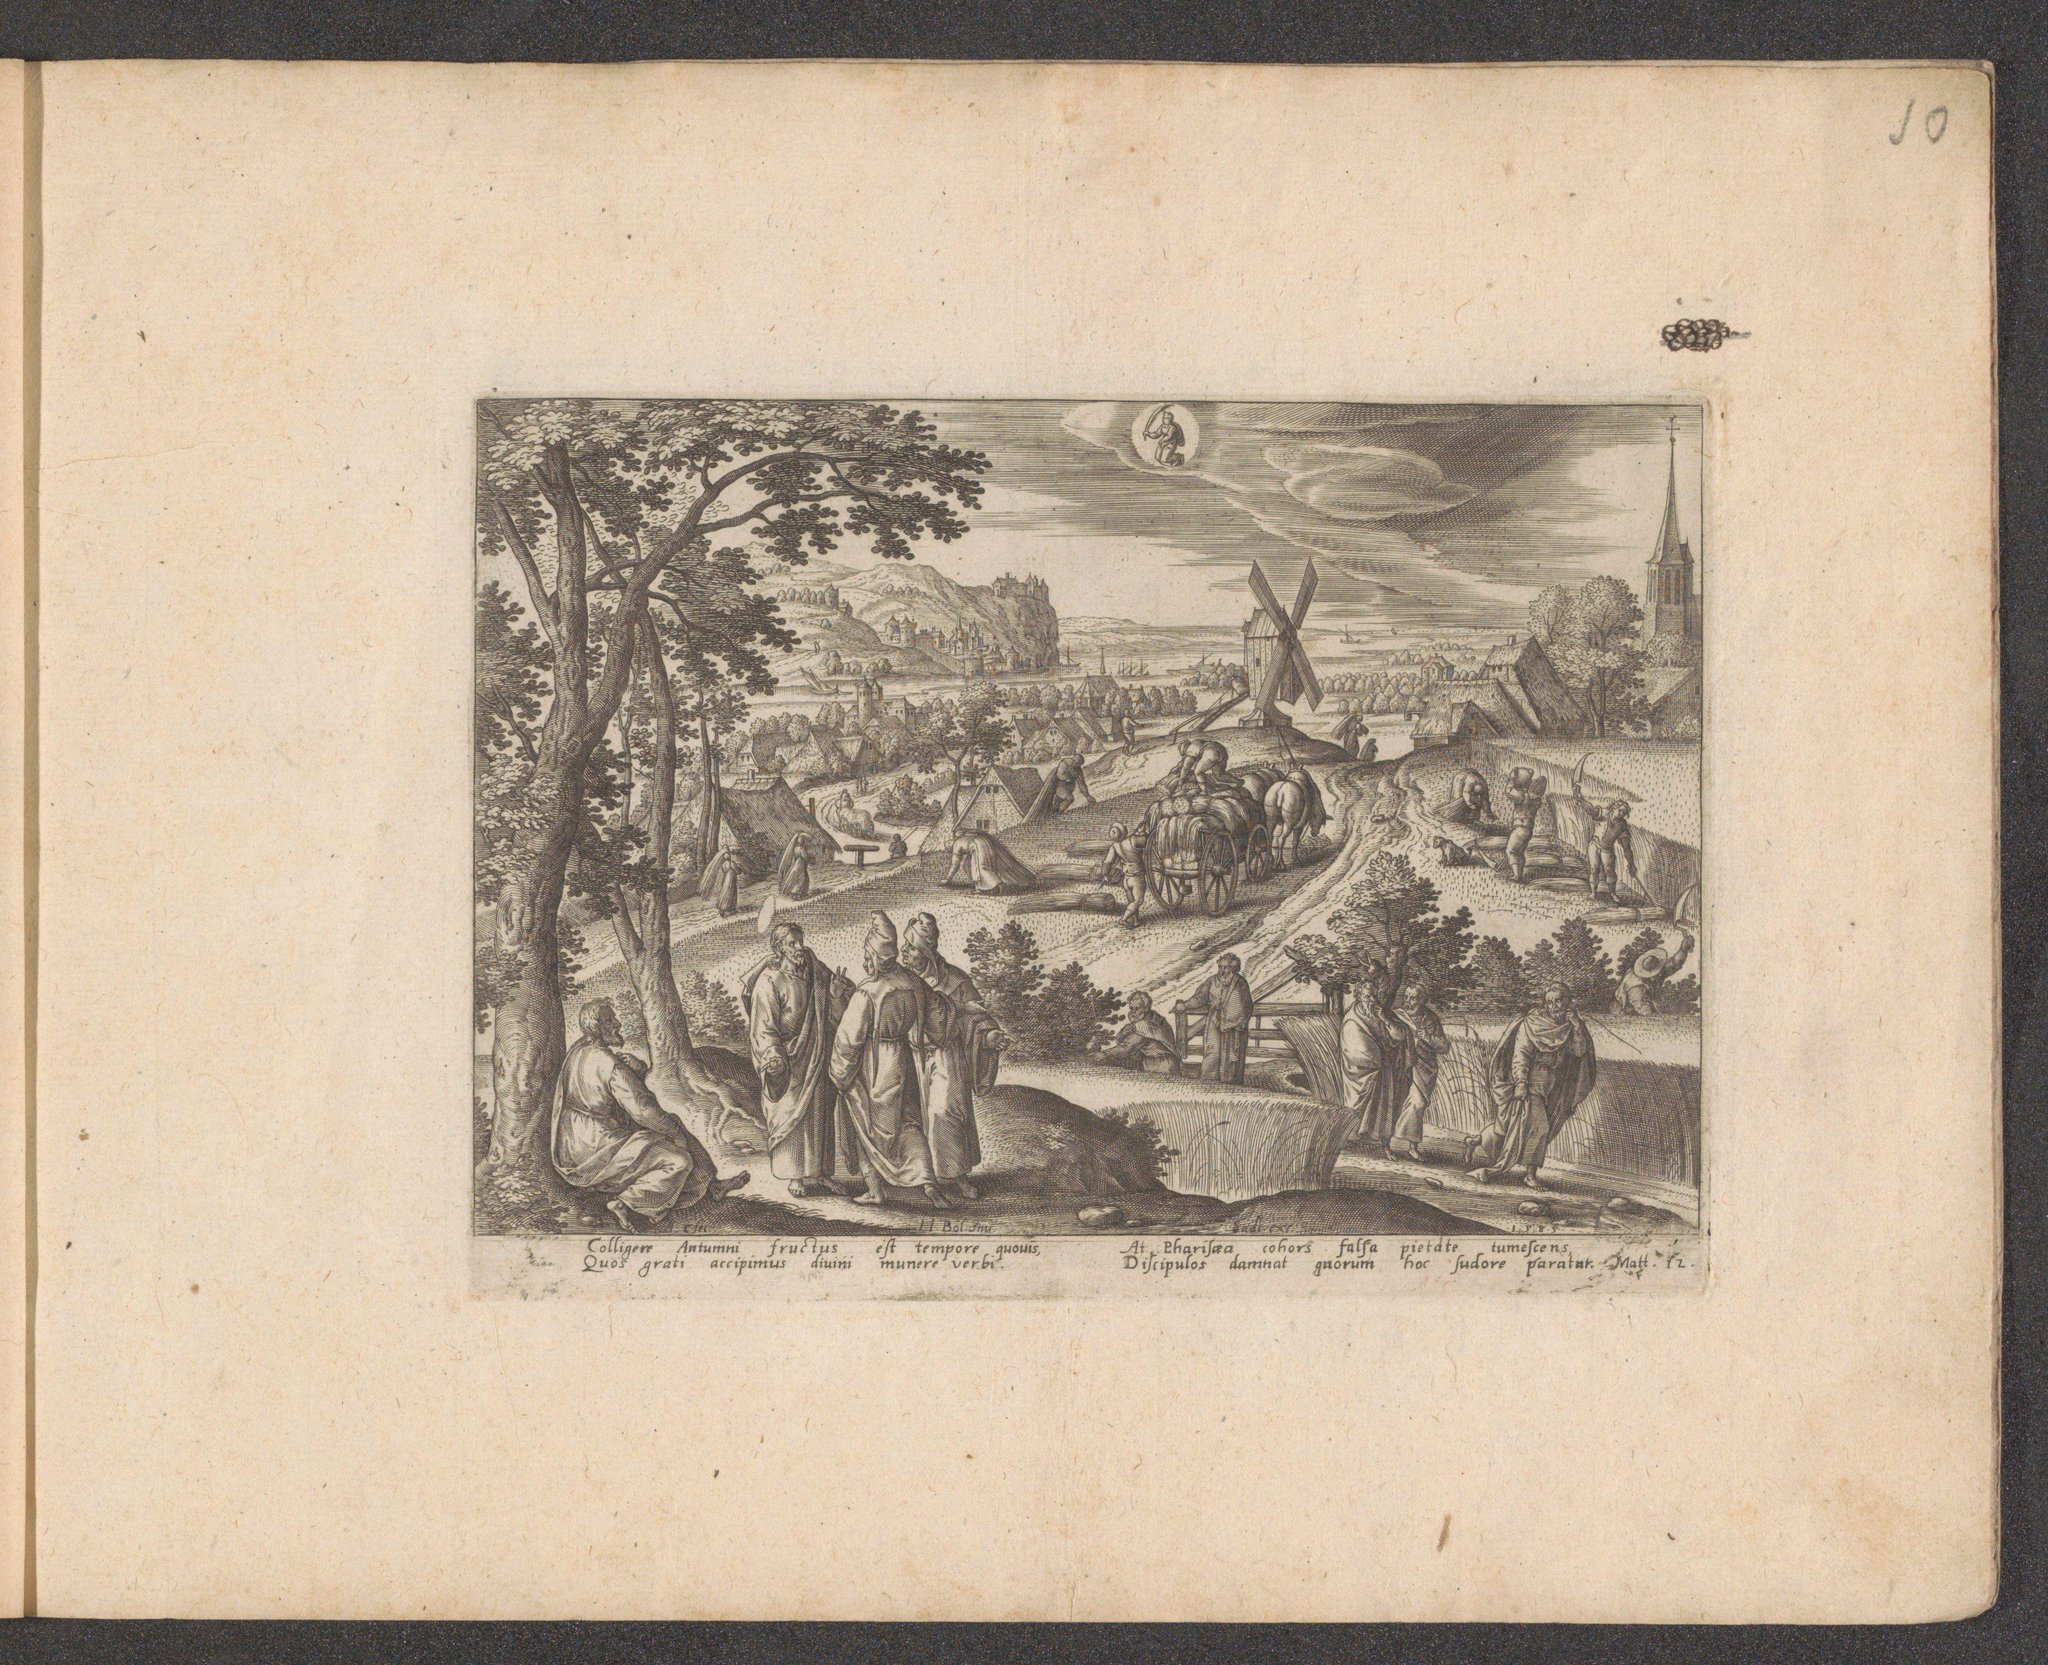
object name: album leaf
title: Augustus: plukken van koren op sabbath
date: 1585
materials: paper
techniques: engraving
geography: antwerp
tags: virgo (zodiacal sign of august), harvest, landscape symbolizing august, august ~ other concepts (+ with zodiacal signs), disciples pluck ears of corn on sabbath, and eat (matthew 12:1-8; mark 2:23-28; luke 6:1-5)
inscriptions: date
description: Middenboven het sterrebeeld Maagd. Links op de voorgrond Christus met enkele Farizeeën, die hem wijzen op de apostelen die koren plukken op sabbath. Rechts een korenoogst. Molen op de achtergrond. Onder de voorstelling vier regels Latijn in twee kolommen (Mat. 12). De prent maakt deel uit van een album.